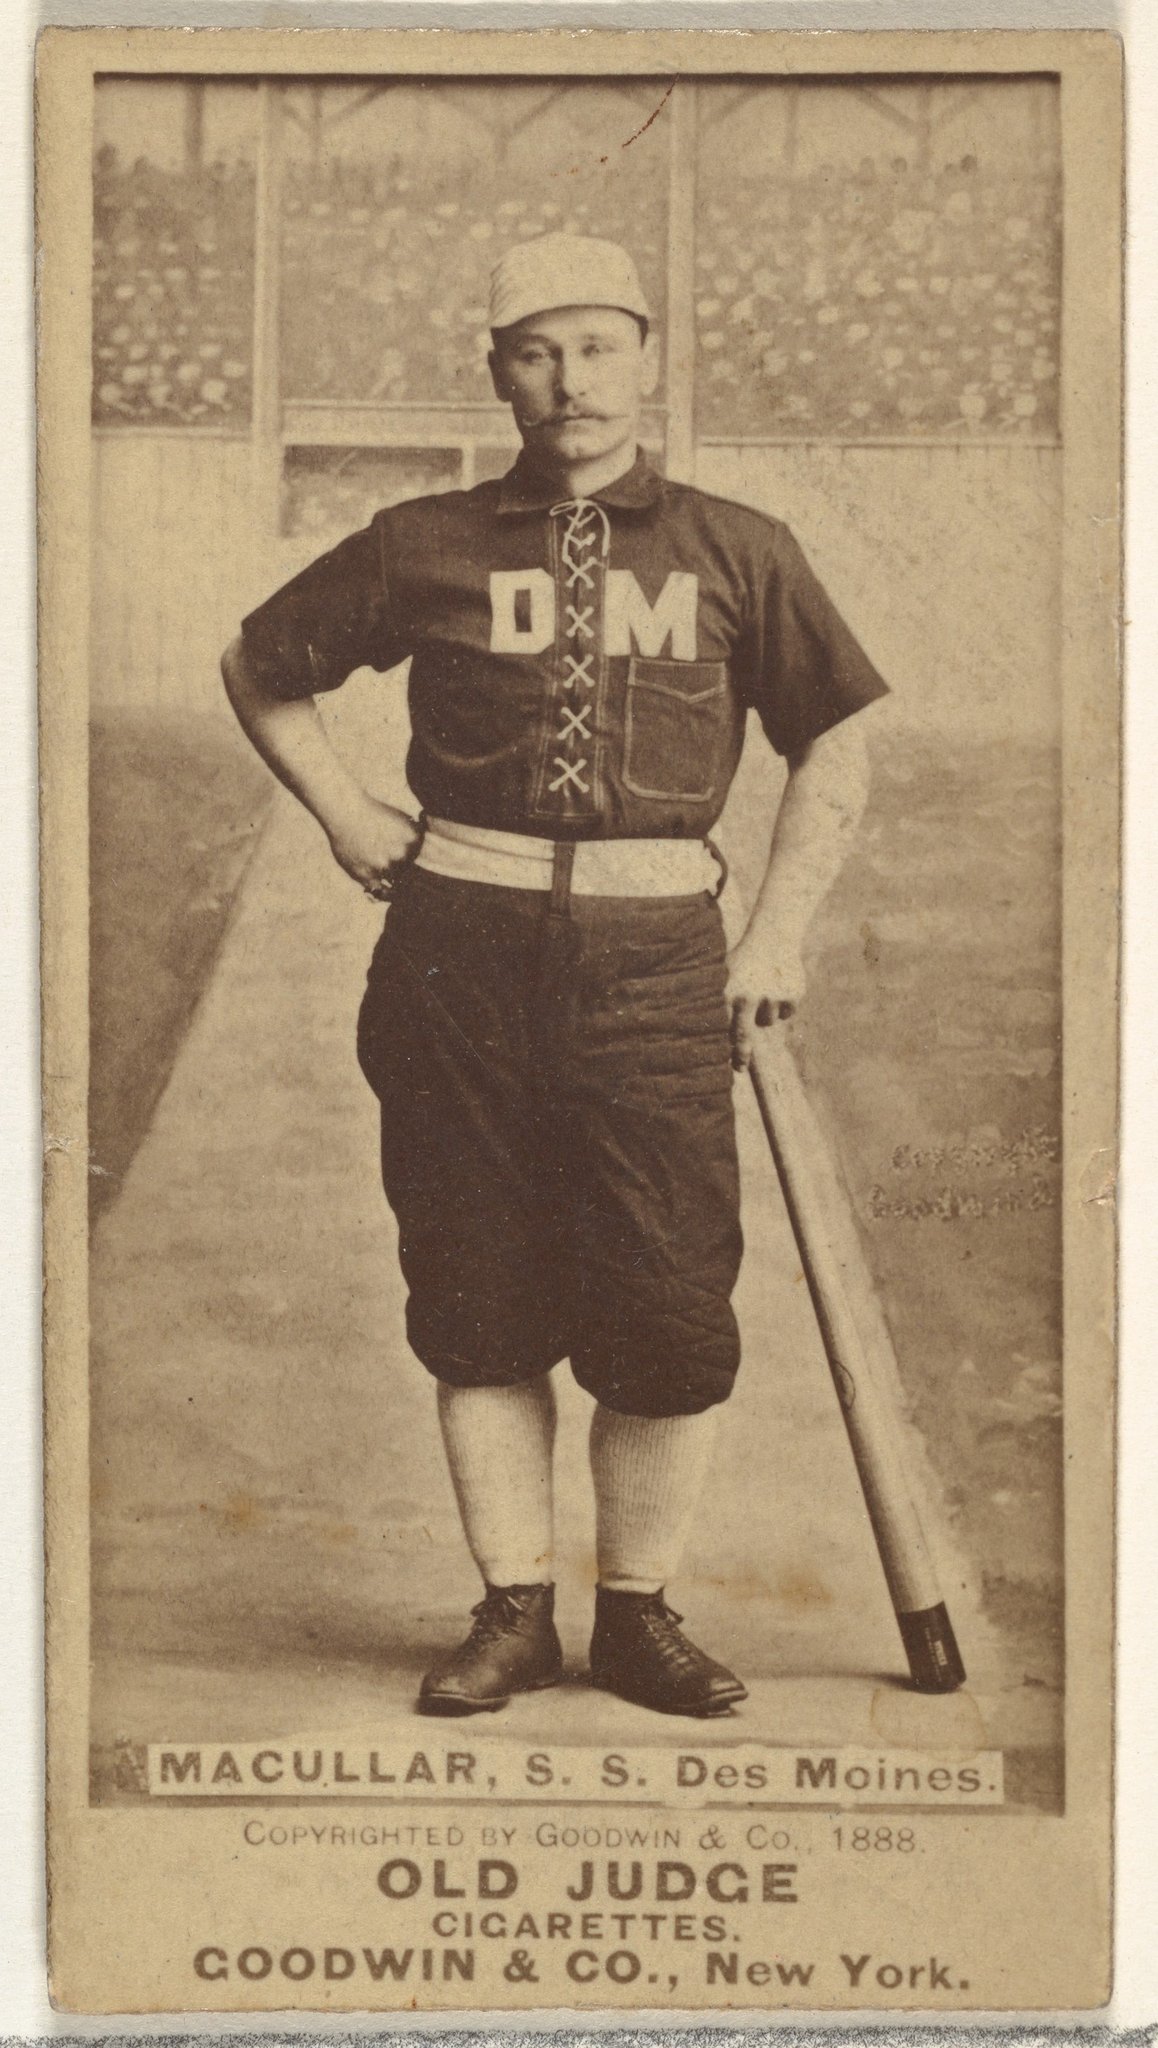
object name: baseball card, photograph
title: James F. "Jimmy" Macullar, Shortstop, Des Moines Prohibitionists, from the Old Judge series (N172) for Old Judge Cigarettes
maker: goodwin & company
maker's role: publisher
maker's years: 1850-1950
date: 1888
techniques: albumen silver print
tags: men,portraits,baseball,athletes